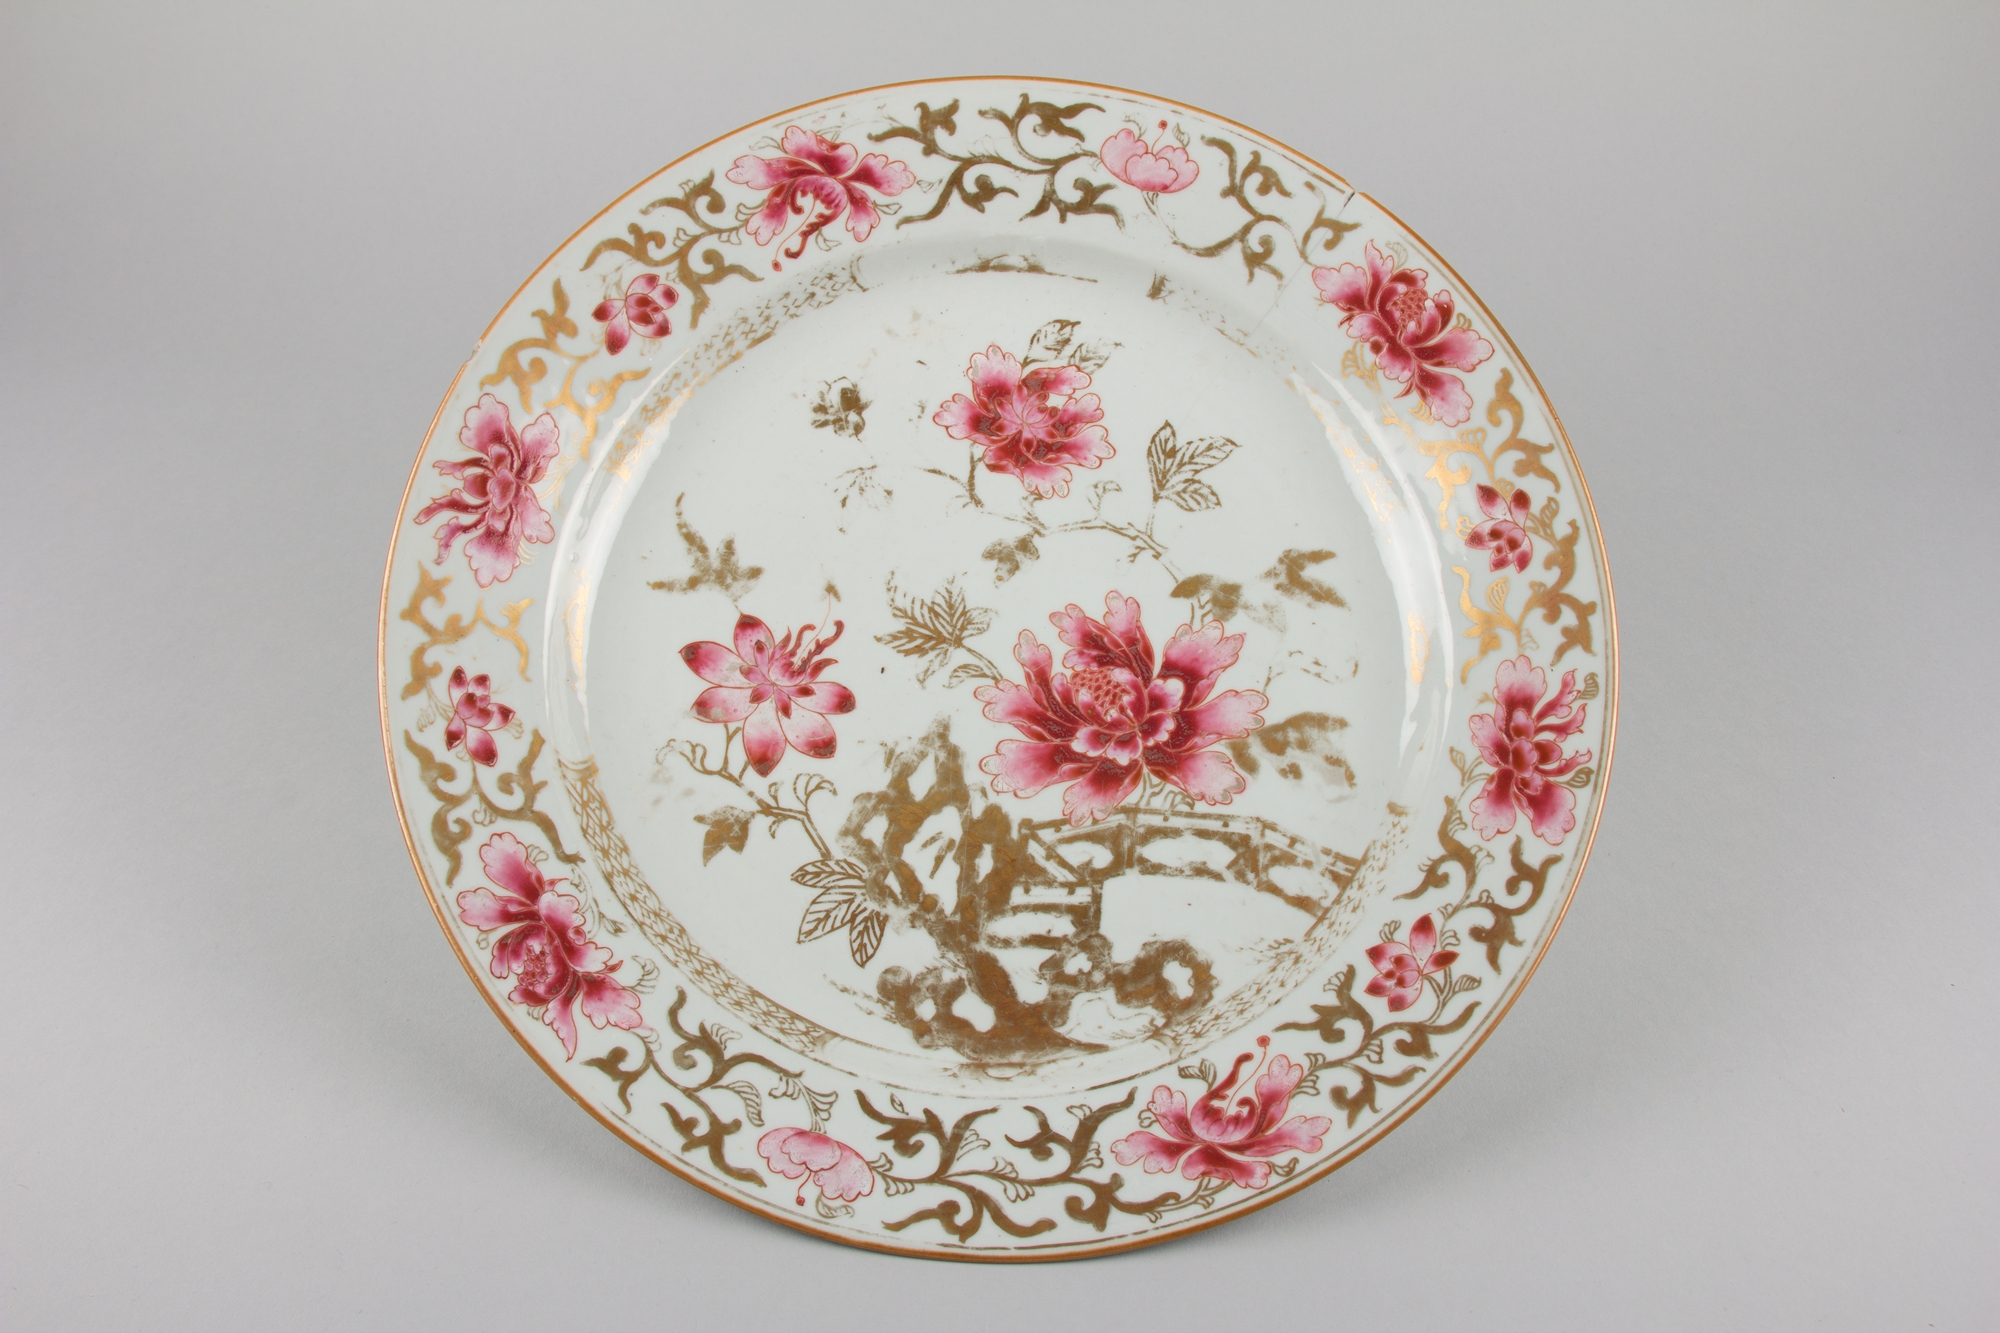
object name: dish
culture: chinese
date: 1767-1900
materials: enamel, porcelain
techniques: overglaze, painting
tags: flowers